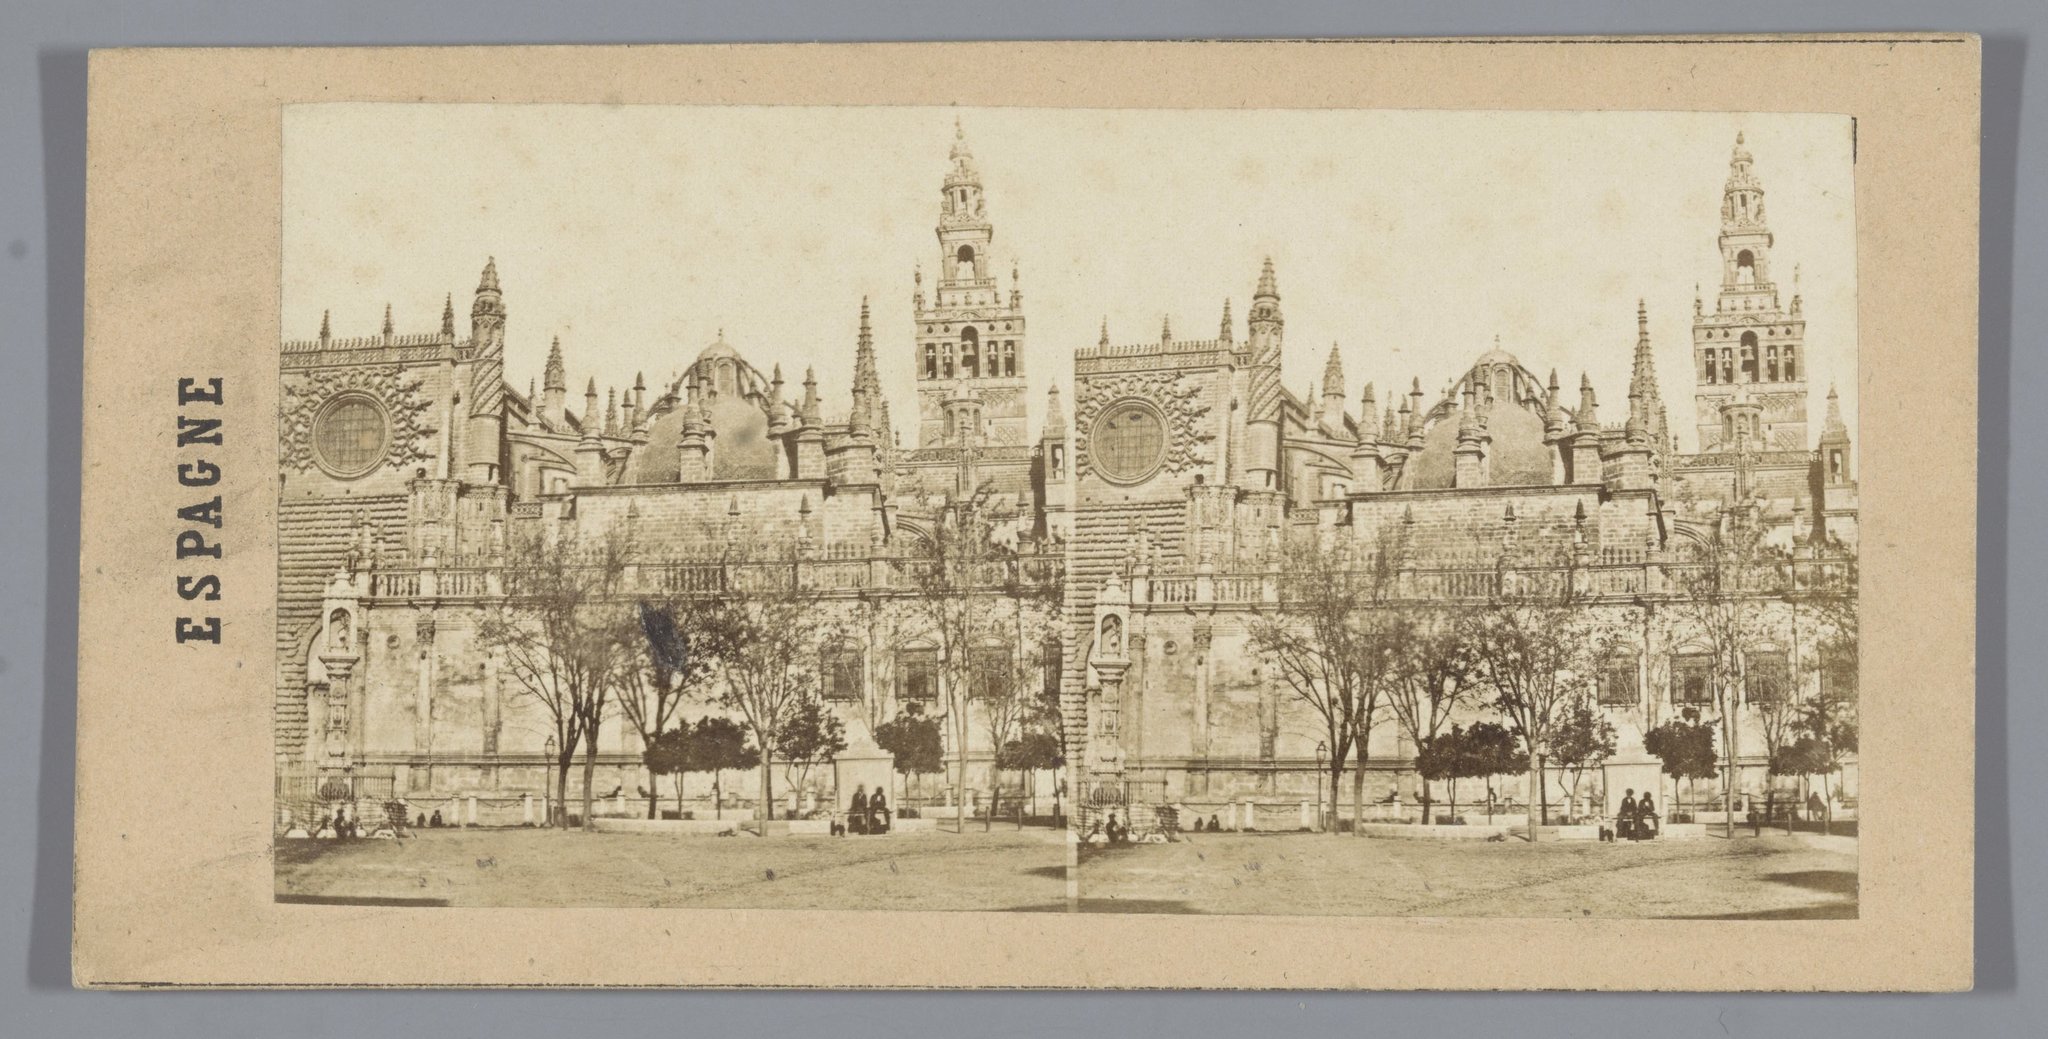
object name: stereograph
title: Exterieur van de Kathedraal van Sevilla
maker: Anonymous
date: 1850-1880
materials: cardboard, photographic support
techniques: albumen print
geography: sevilla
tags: church (exterior), façade (of house or building)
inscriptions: inscription: ‘Espagne.’, number: ‘No 183.’